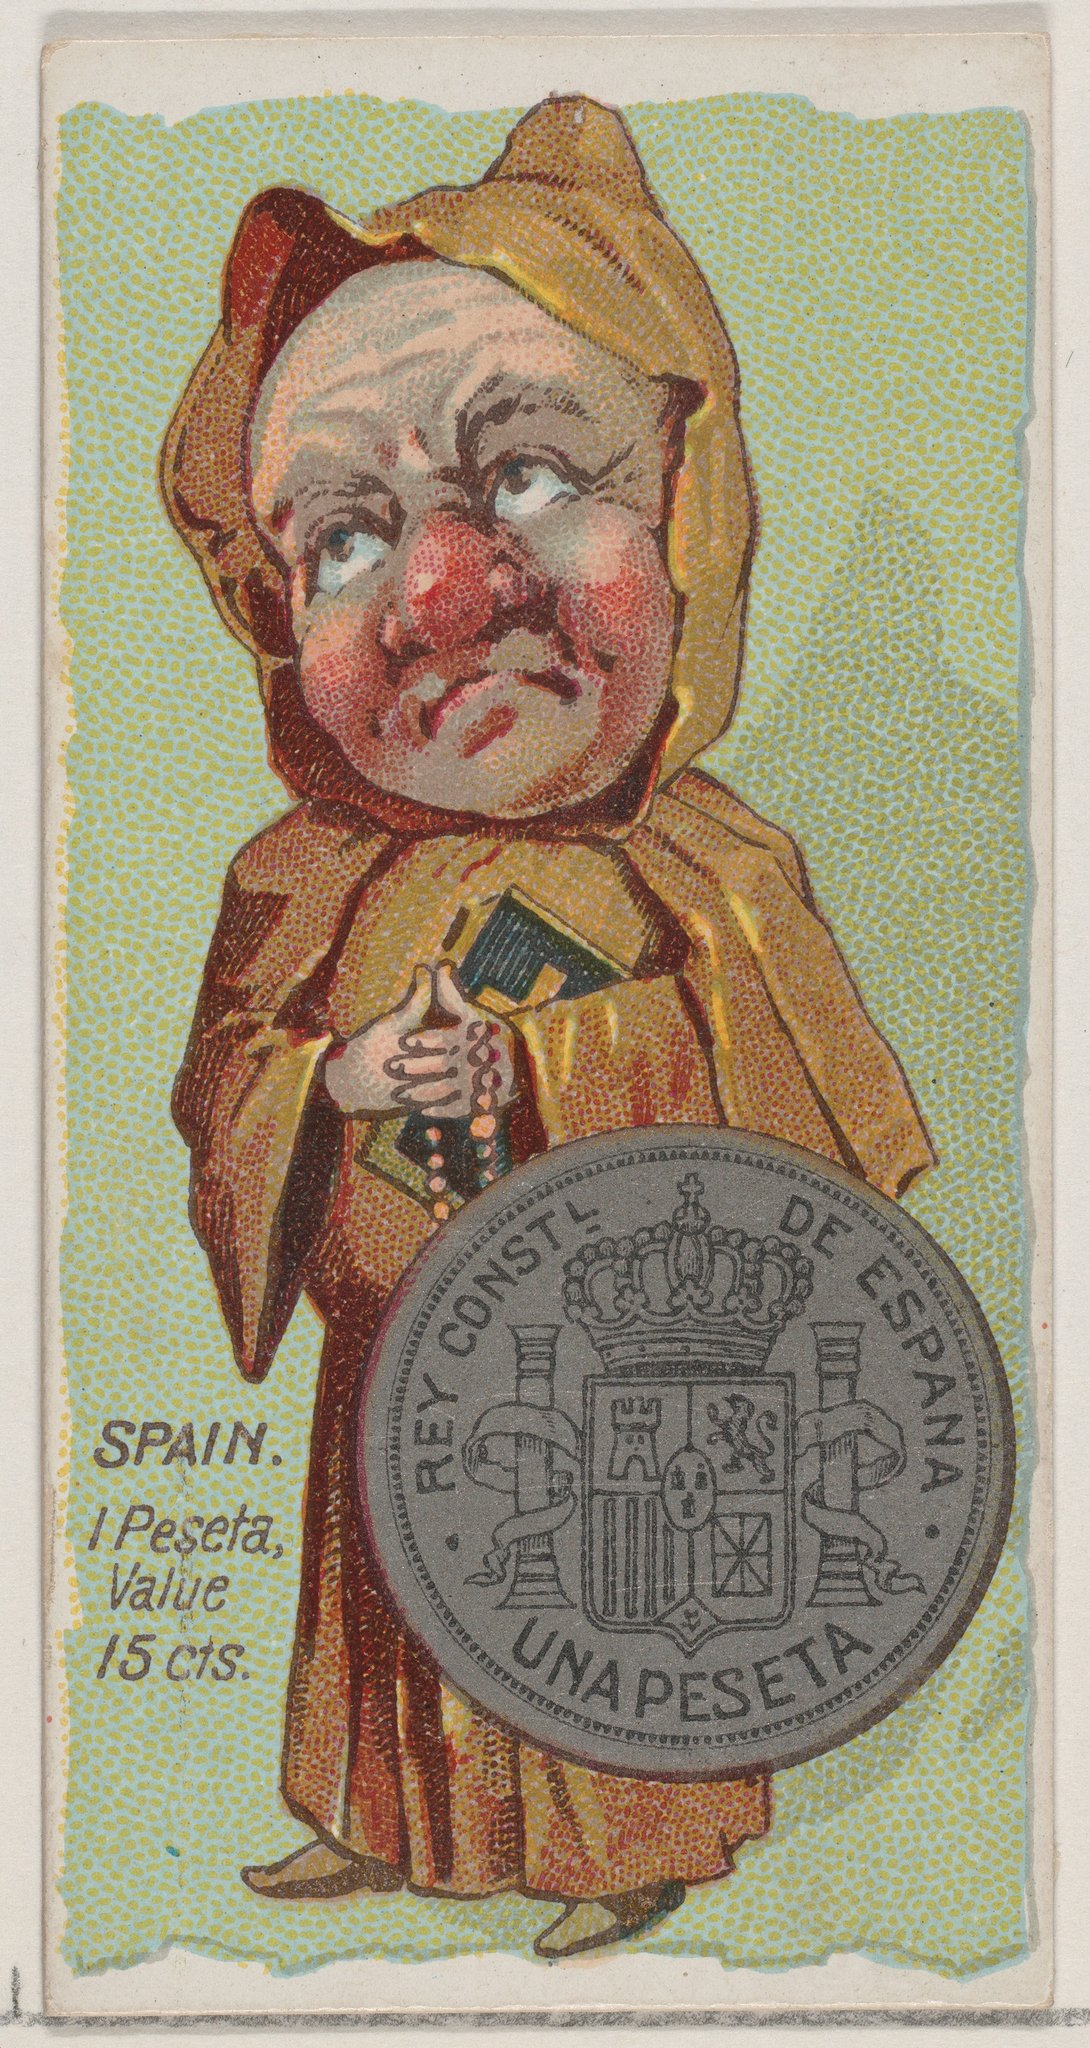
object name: print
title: Caricatured Spaniard, 1 Peseta, from the series Coins of All Nations (N72, variation 2) for Duke brand cigarettes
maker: w. duke, sons & co.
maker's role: publisher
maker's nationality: american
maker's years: 1870-1920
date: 1889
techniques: color lithograph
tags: men,coins